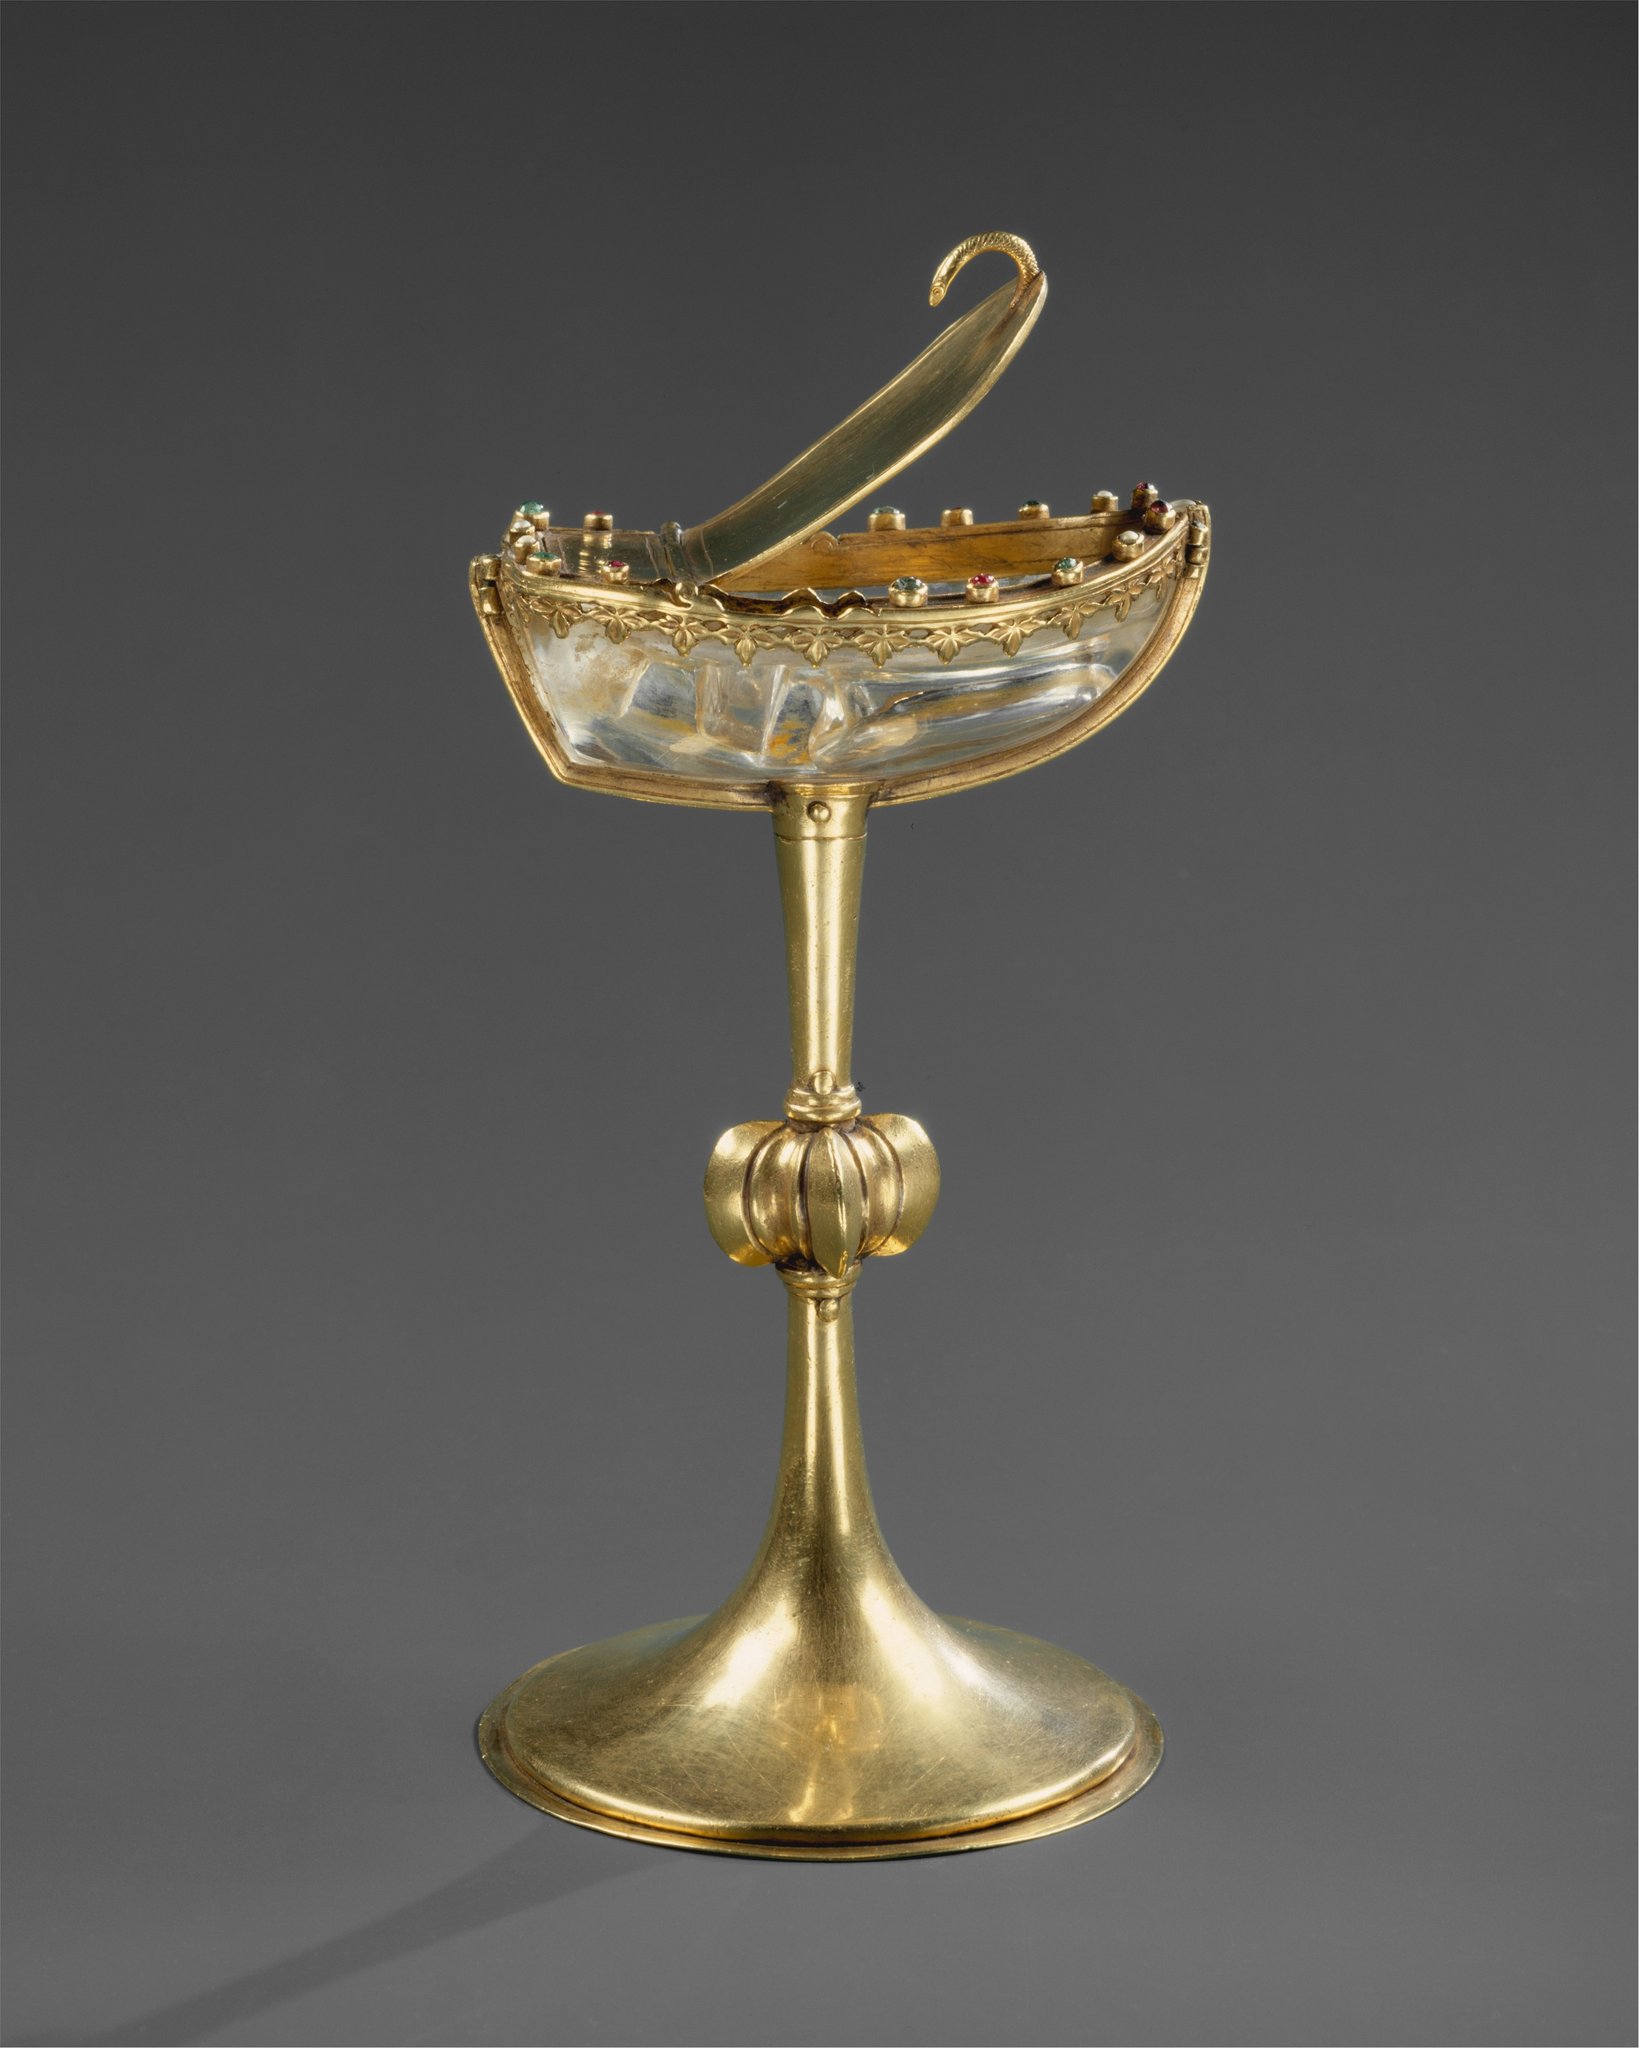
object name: saltcellar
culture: french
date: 1234-1266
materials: gemstone, gold, pearl, quartz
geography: france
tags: serpents,boats